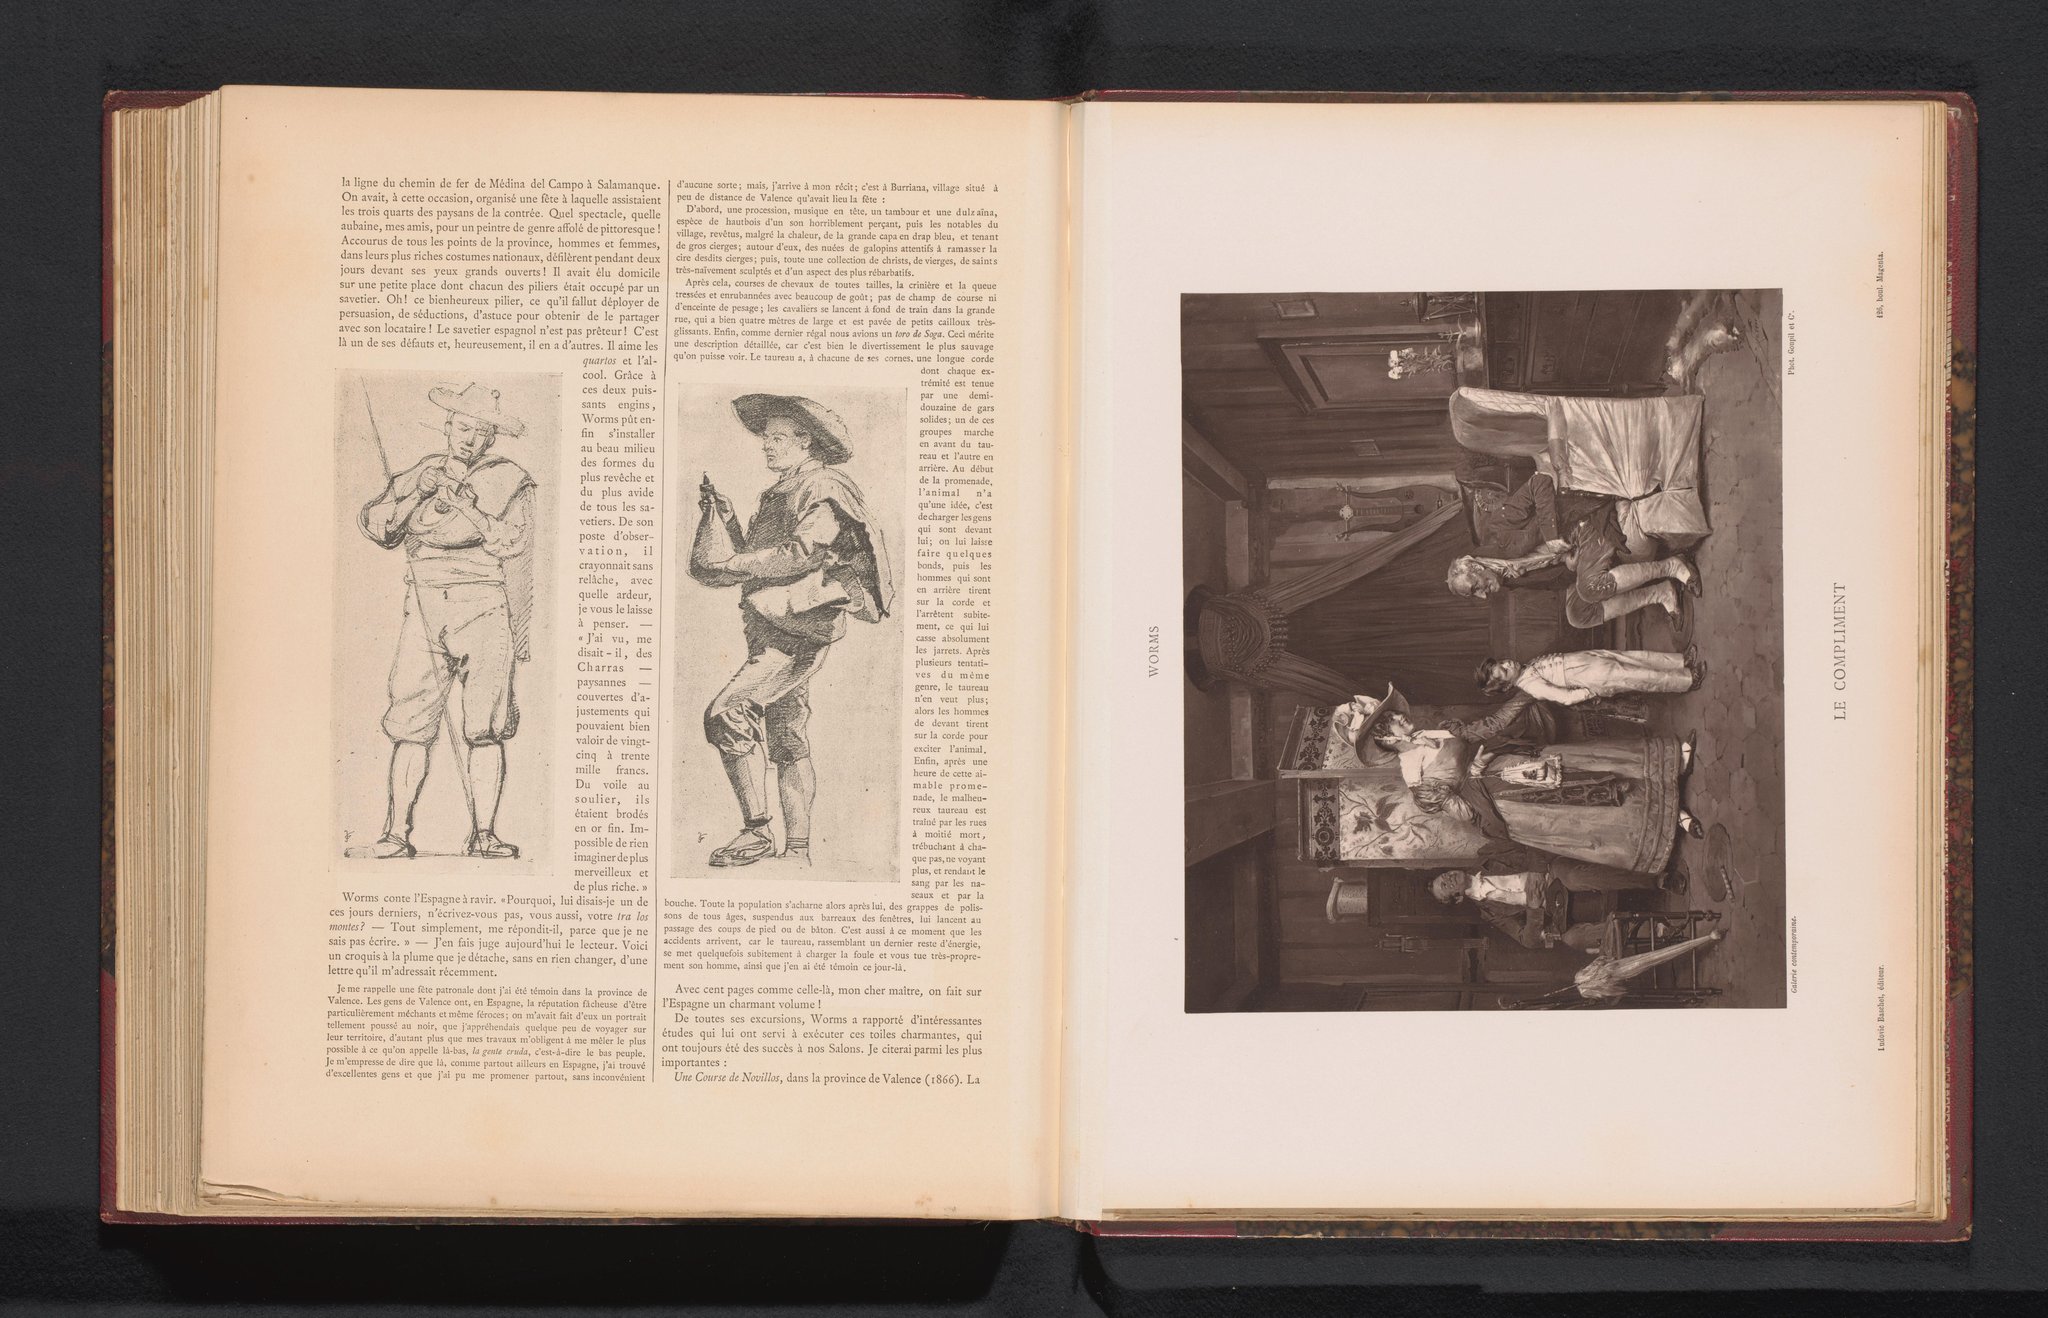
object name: page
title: Reproductie van Le compliment door Jules Worms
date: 1873-1878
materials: paper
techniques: woodburytype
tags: family, relationship, descent, interior of the house, painting, drawing and the graphic arts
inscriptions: inscription: ‘Worms/ Galerie Contemporaine/ Ludovic Baschet, éditeur./ 126 boul. Magenta.’